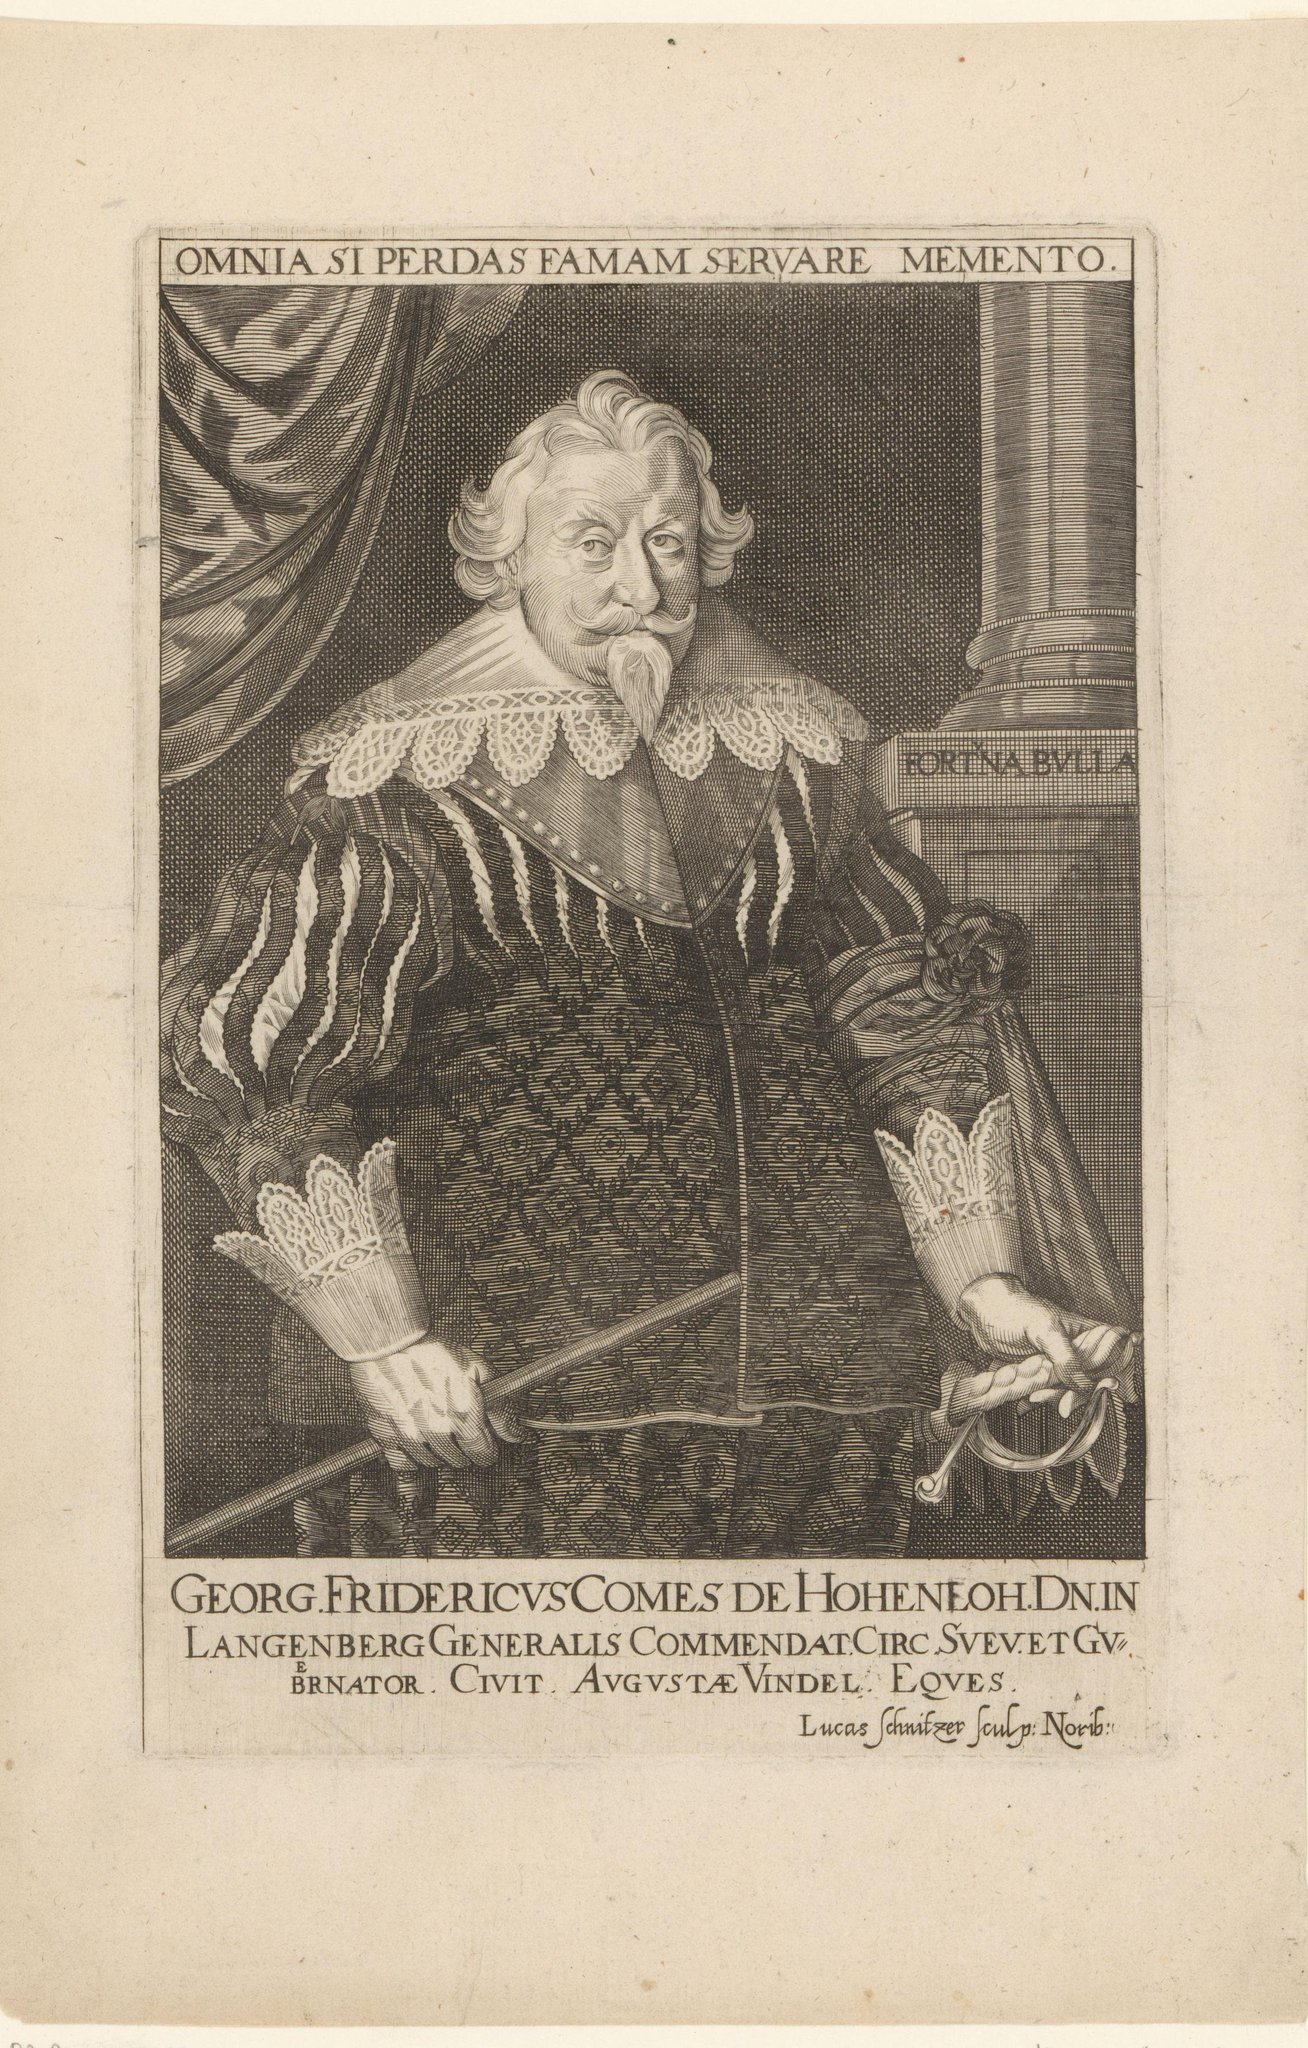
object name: print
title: Portret van Georg Friedrich, graaf van Hohenlohe-Langenburg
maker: lukas schnitzer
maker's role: draughtsman, painter, print maker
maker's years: 1600-1674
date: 1610-1671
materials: paper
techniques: engraving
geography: nuremberg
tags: historical persons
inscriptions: collector's mark: Lugt 2228